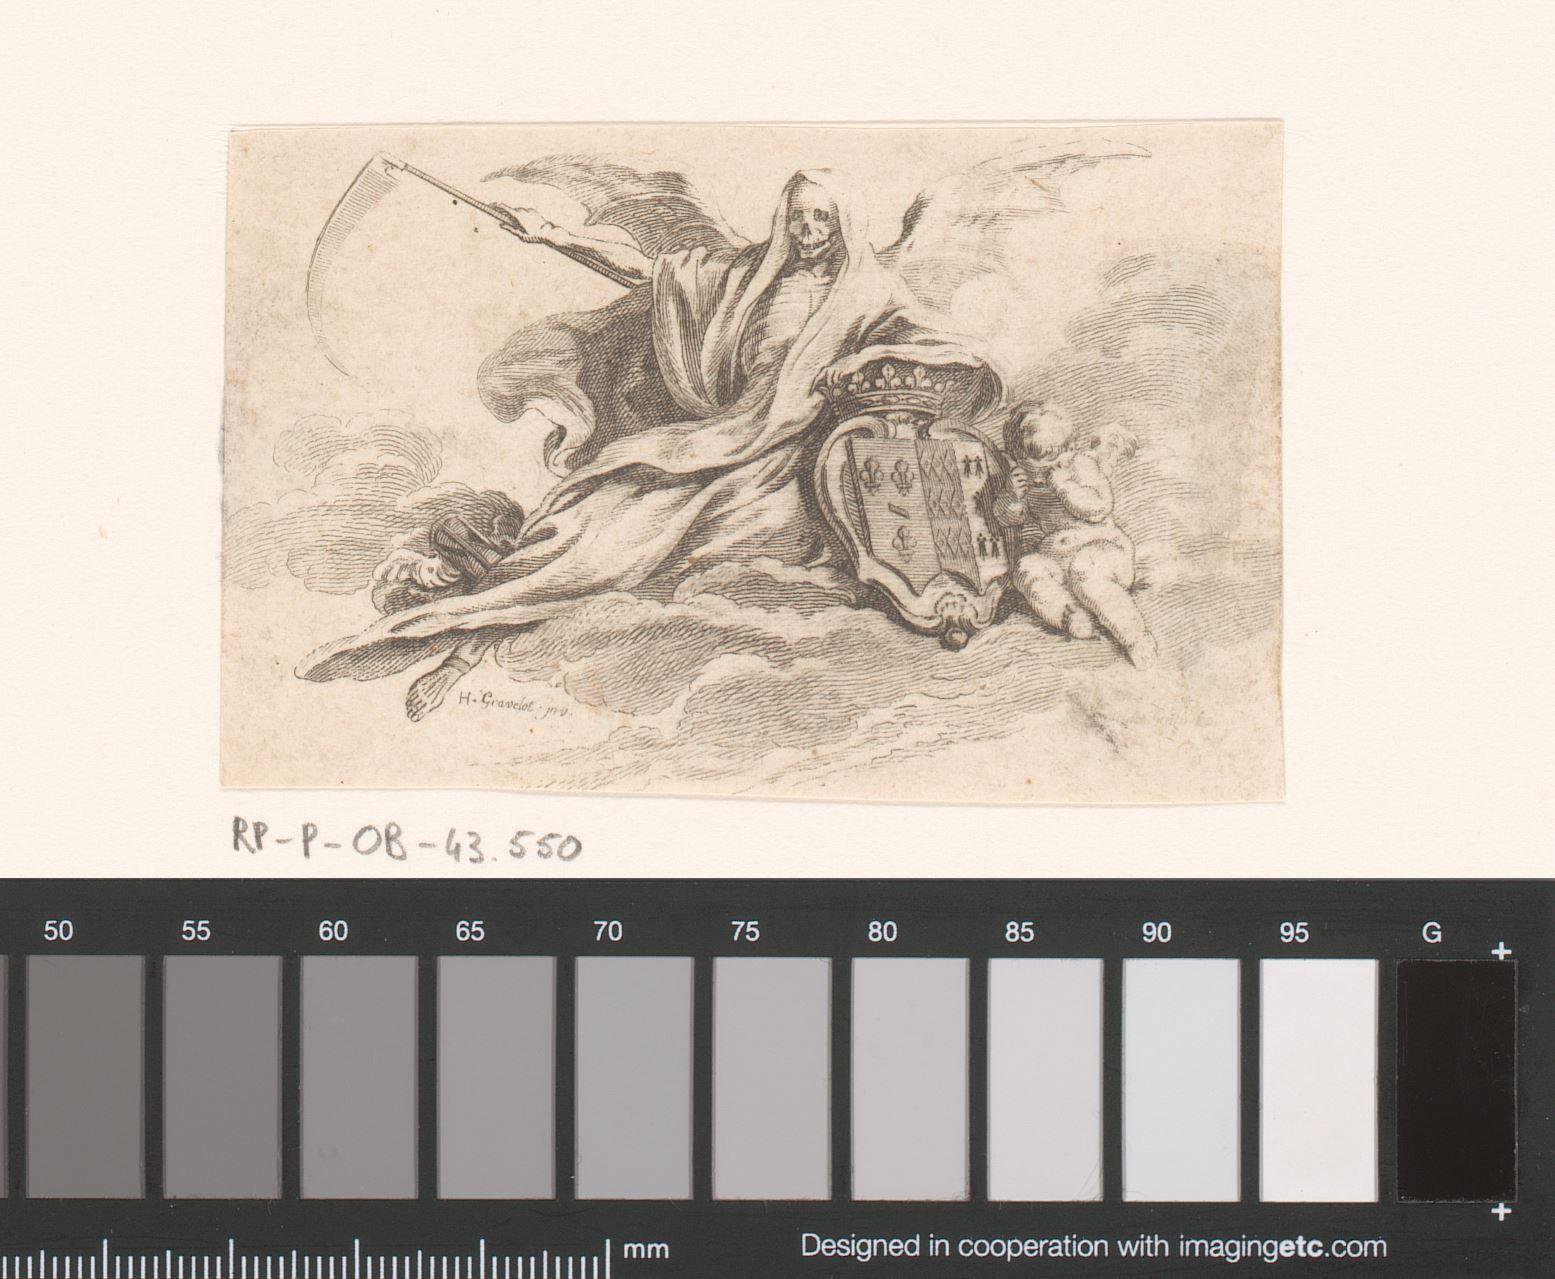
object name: print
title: Personificatie van de Dood met sikkel en een putto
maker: hubert françois gravelot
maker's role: draughtsman, painter, print maker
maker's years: 1699-1773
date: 1709-1773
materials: paper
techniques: etching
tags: death as skeleton, cupids: 'amores', 'amoretti', 'putti', armorial bearing, heraldry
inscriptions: collector's mark: Lugt 2228